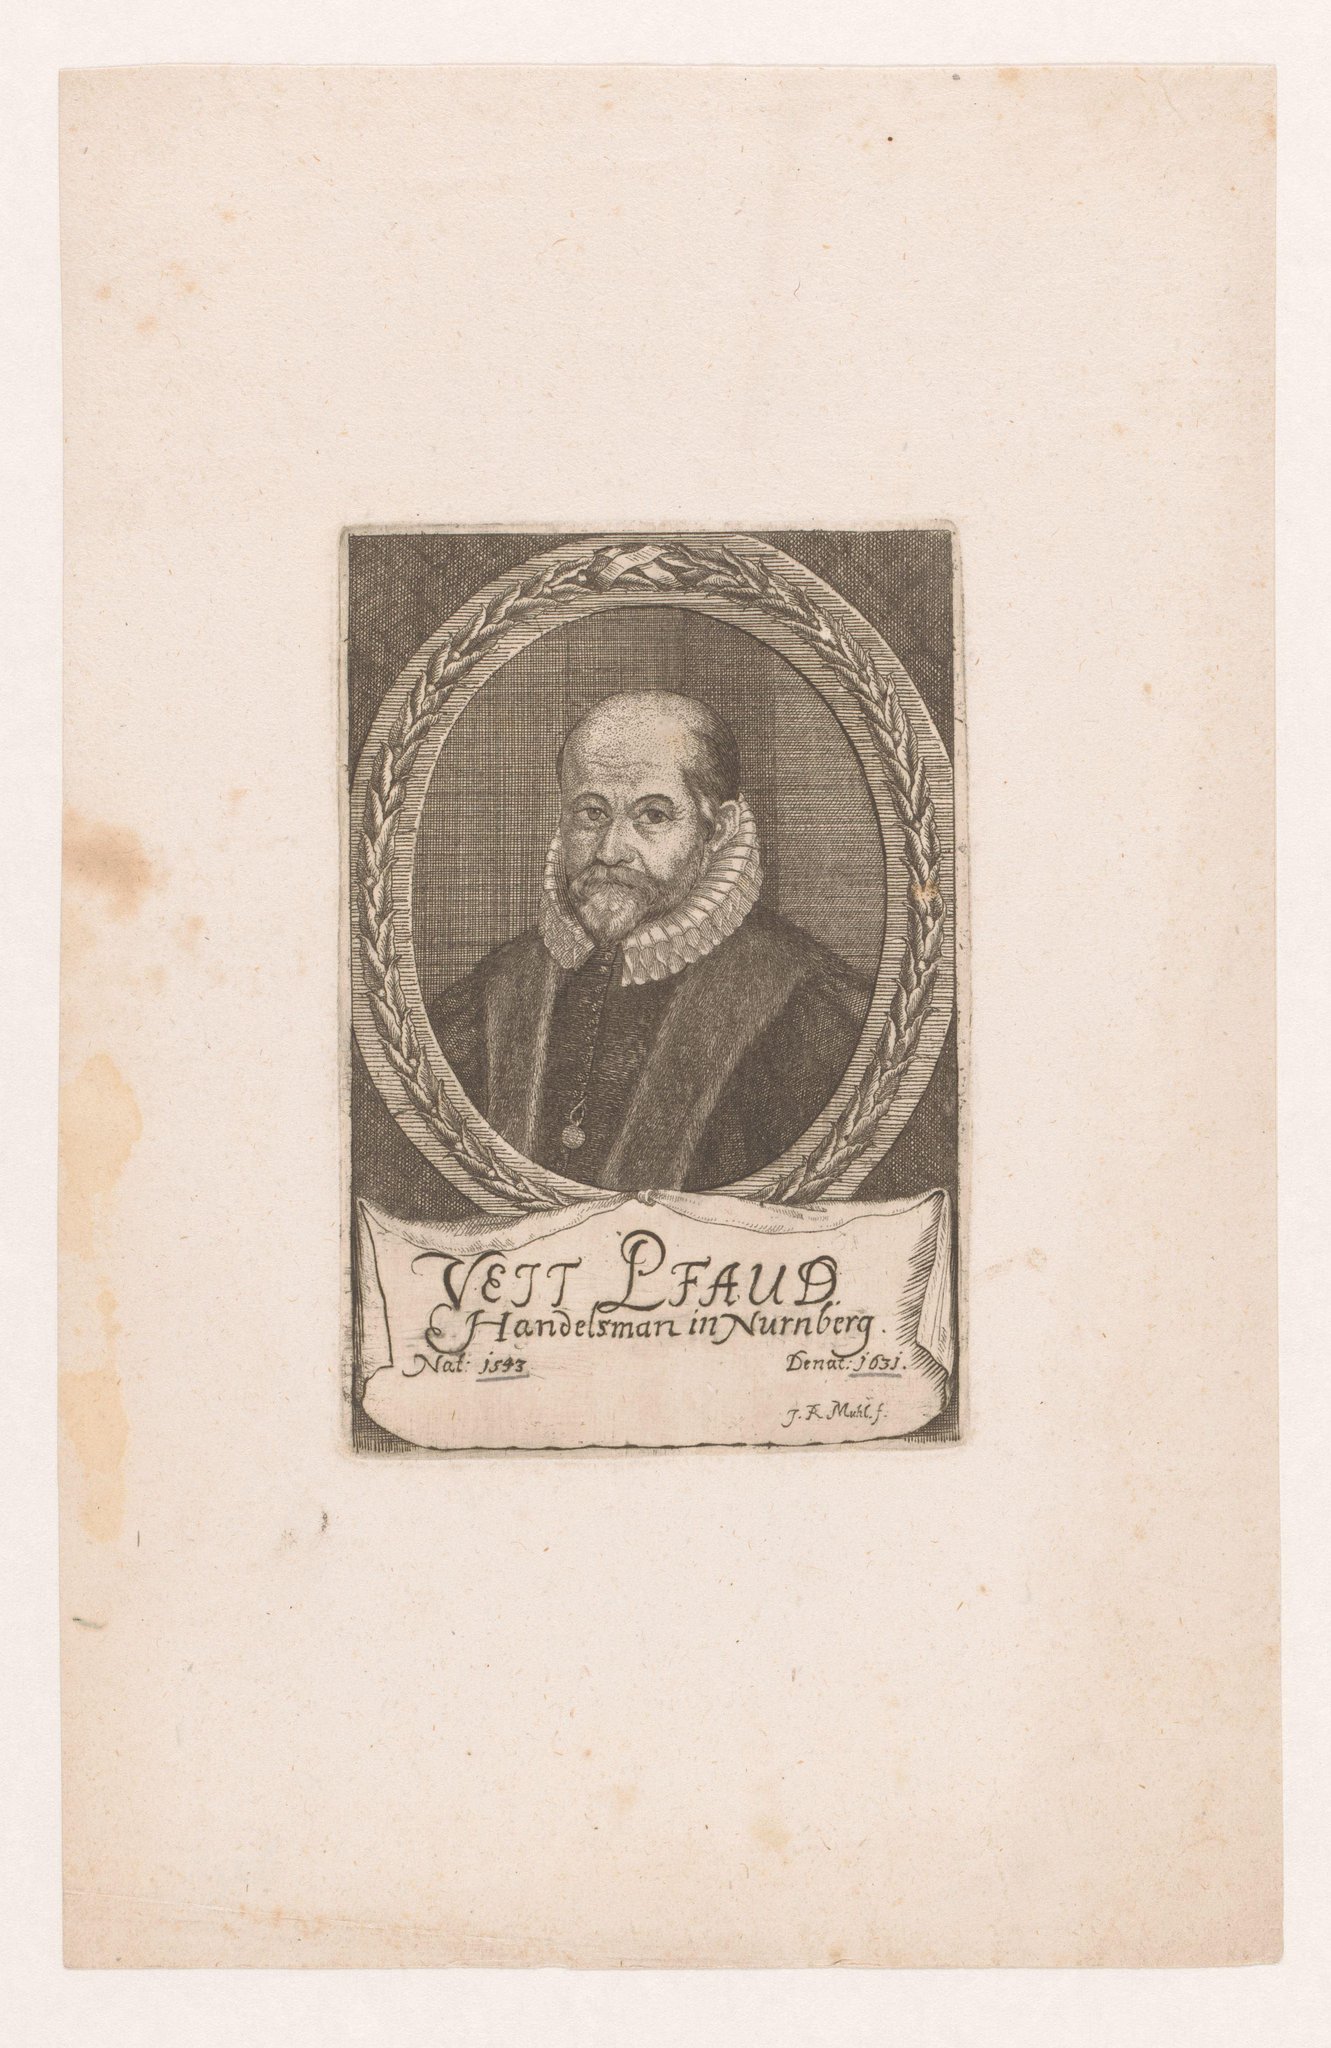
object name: print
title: Portret van Veit Pfaud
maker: johann reinhold mühl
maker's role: print maker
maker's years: 1631-1692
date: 1631-1692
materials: paper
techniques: etching, engraving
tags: historical persons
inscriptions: collector's mark: Lugt 2228